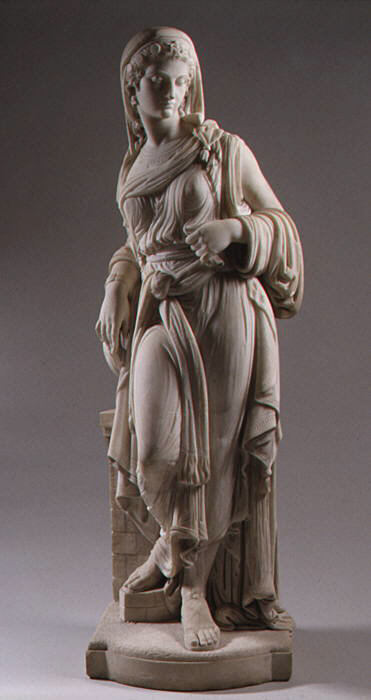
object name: statuette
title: Rebecca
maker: john warrington wood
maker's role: artist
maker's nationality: british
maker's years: 1839-1886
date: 1878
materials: marble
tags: women